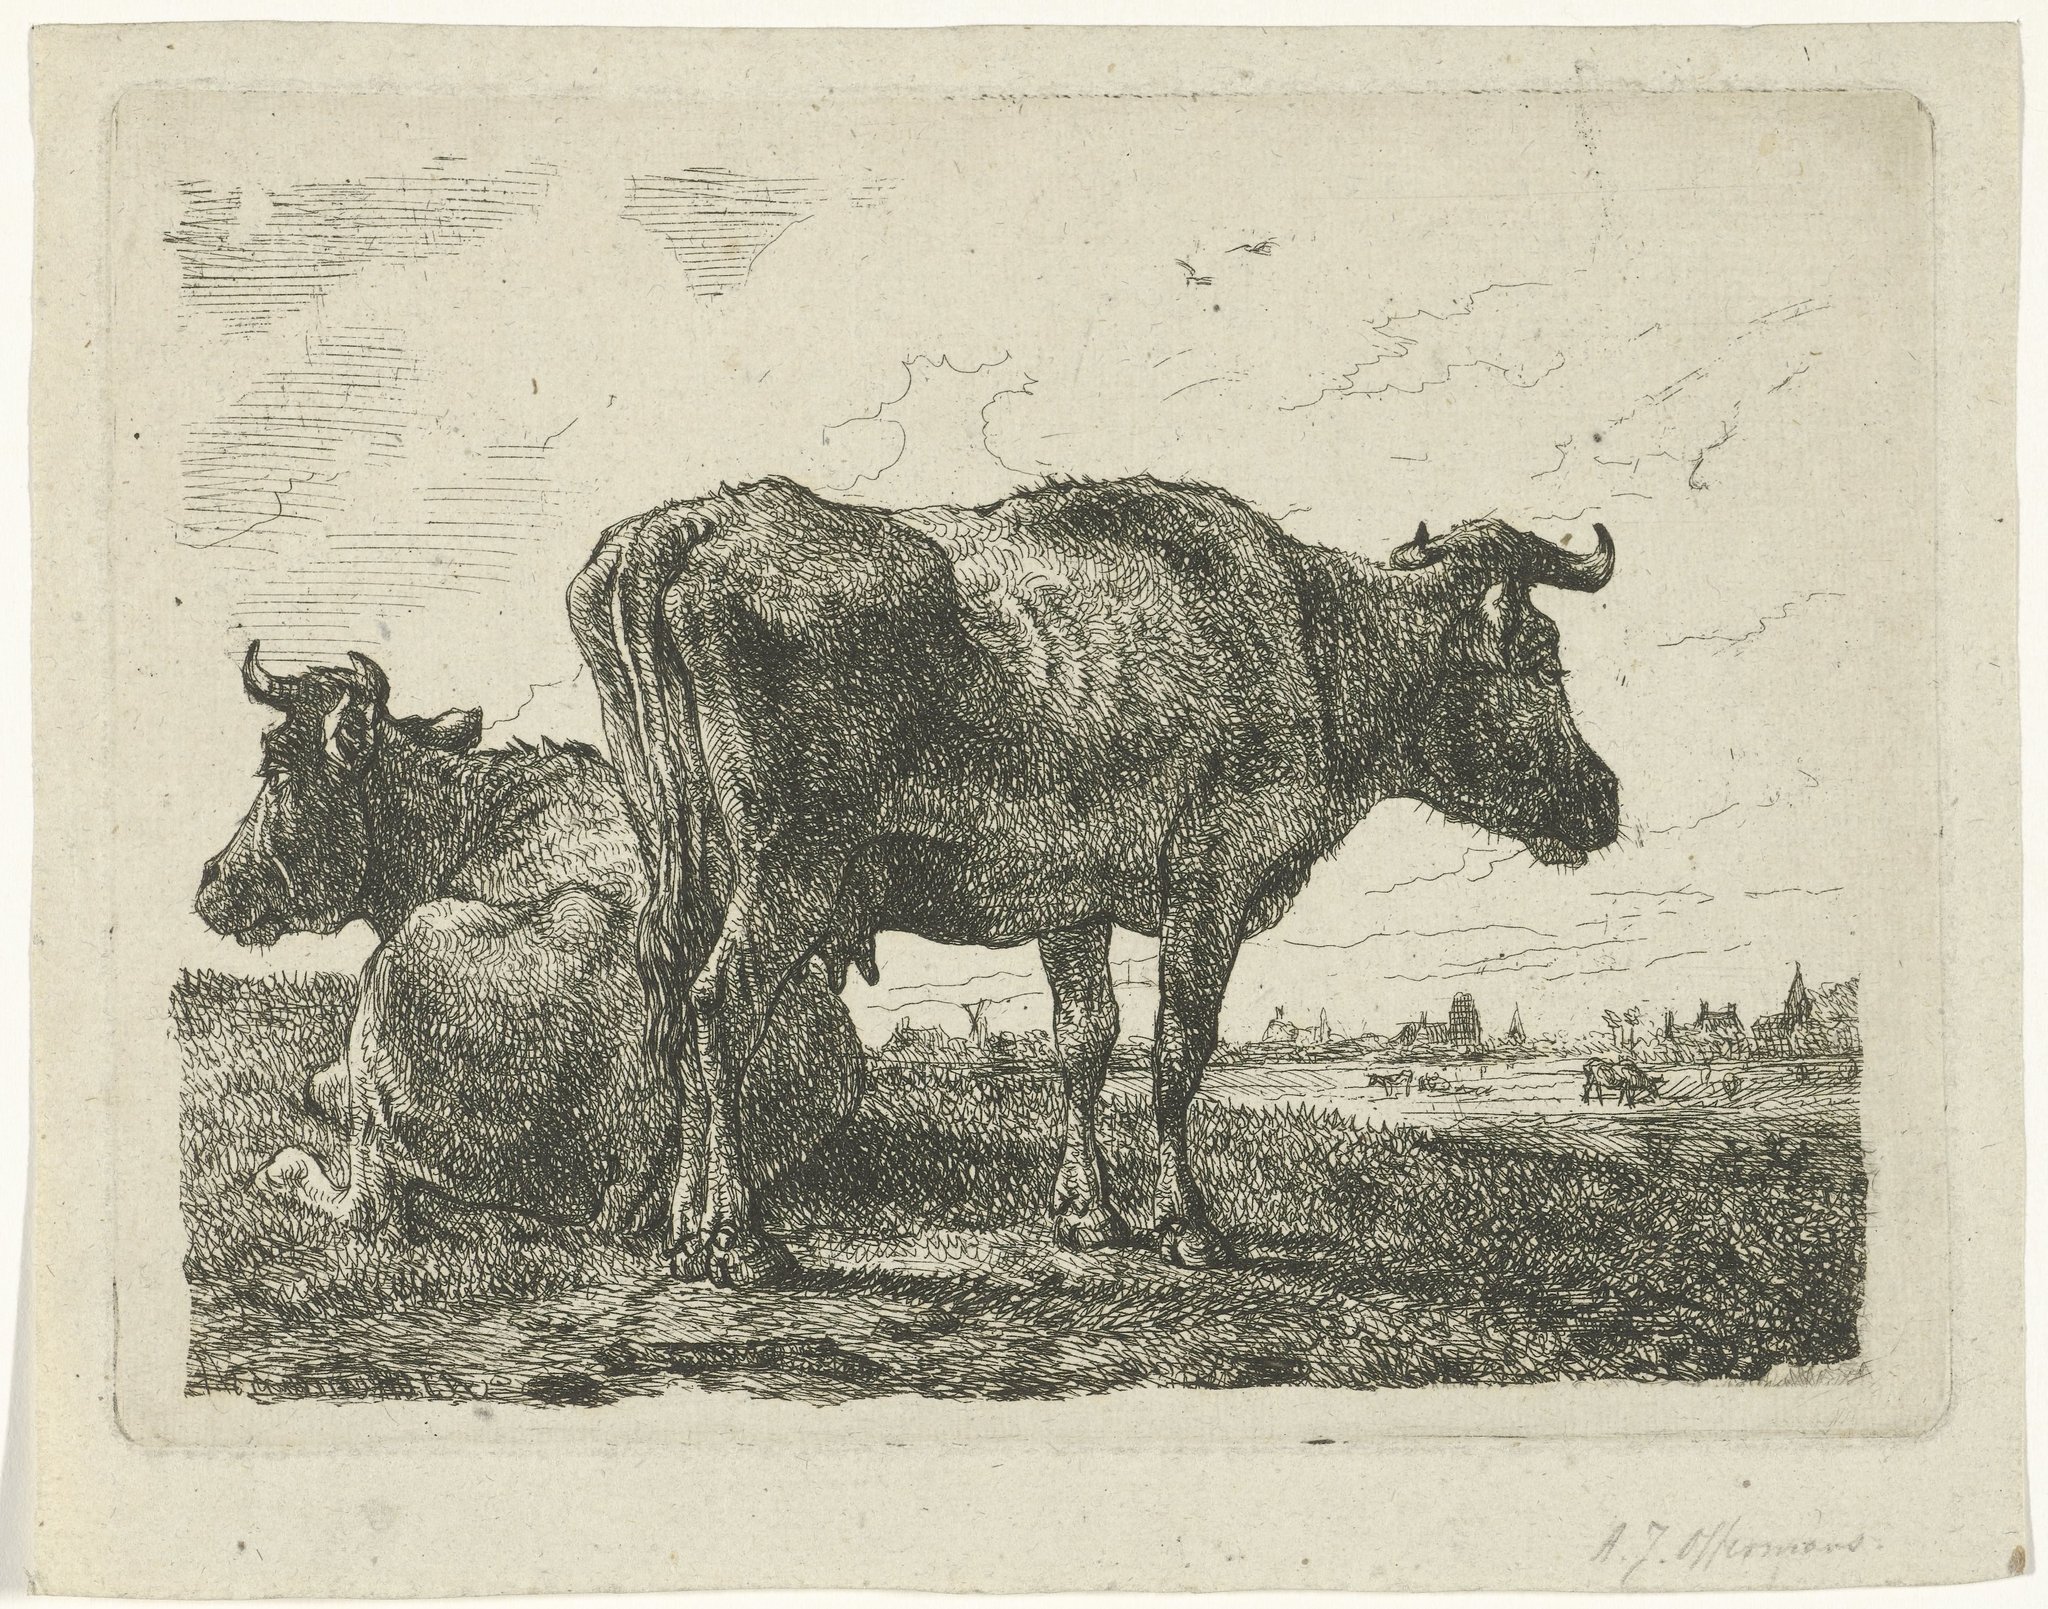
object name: print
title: Twee koeien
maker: anthony jacobus offermans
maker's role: draughtsman, print maker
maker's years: 1796-1872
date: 1815-1872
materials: paper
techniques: etching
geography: netherlands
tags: cow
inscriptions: collector's mark: Lugt 2228